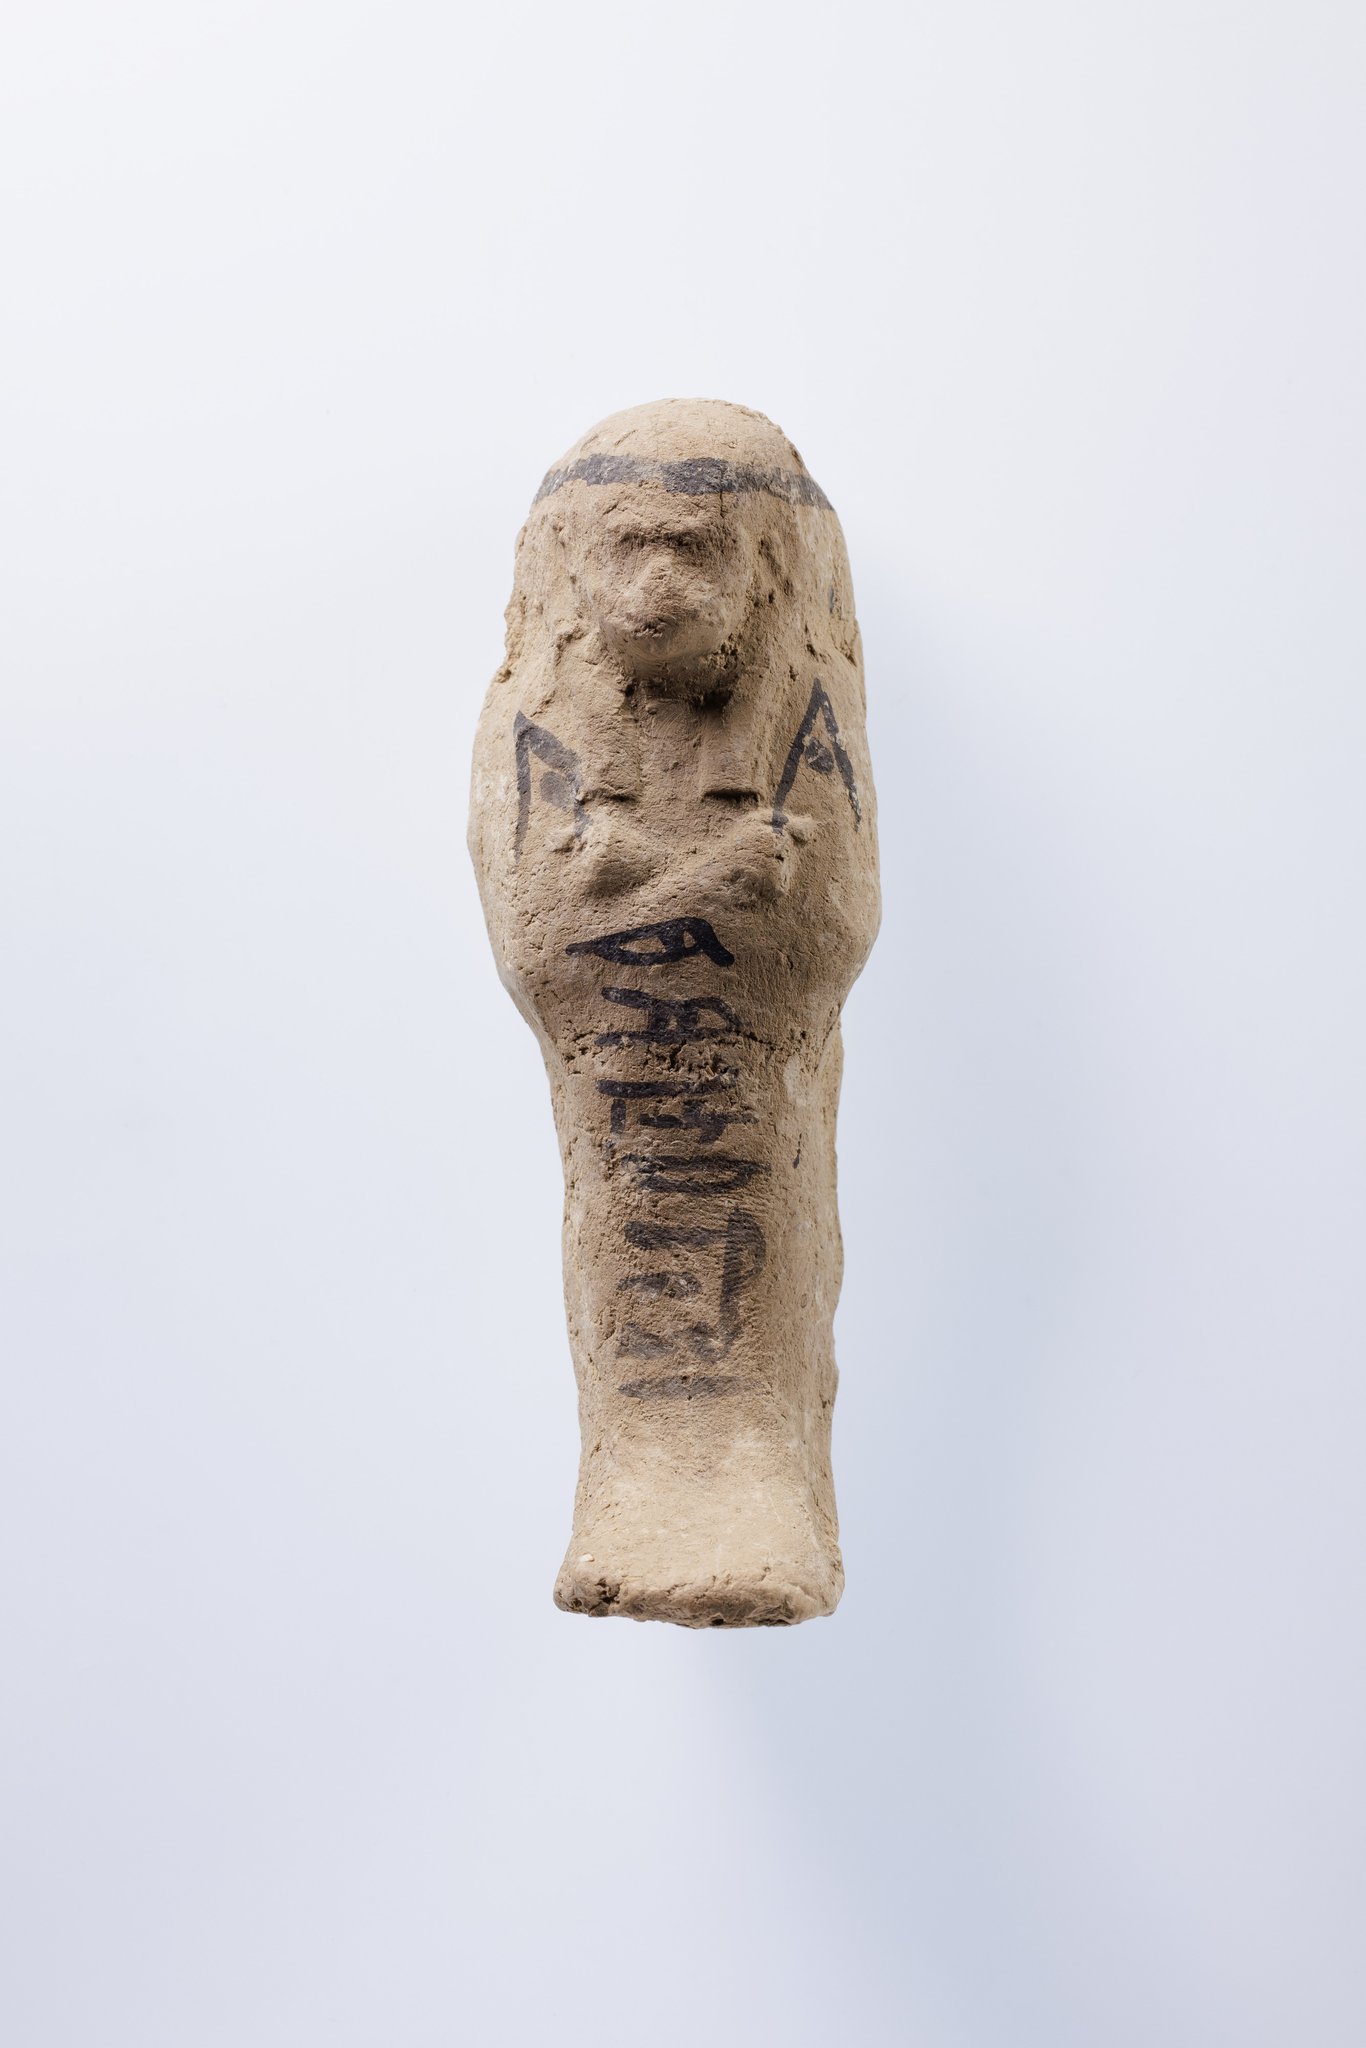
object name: shabti, nesinebtasheru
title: Shabti of Nesinebtasheru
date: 1070-945 BCE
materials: clay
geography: egypt